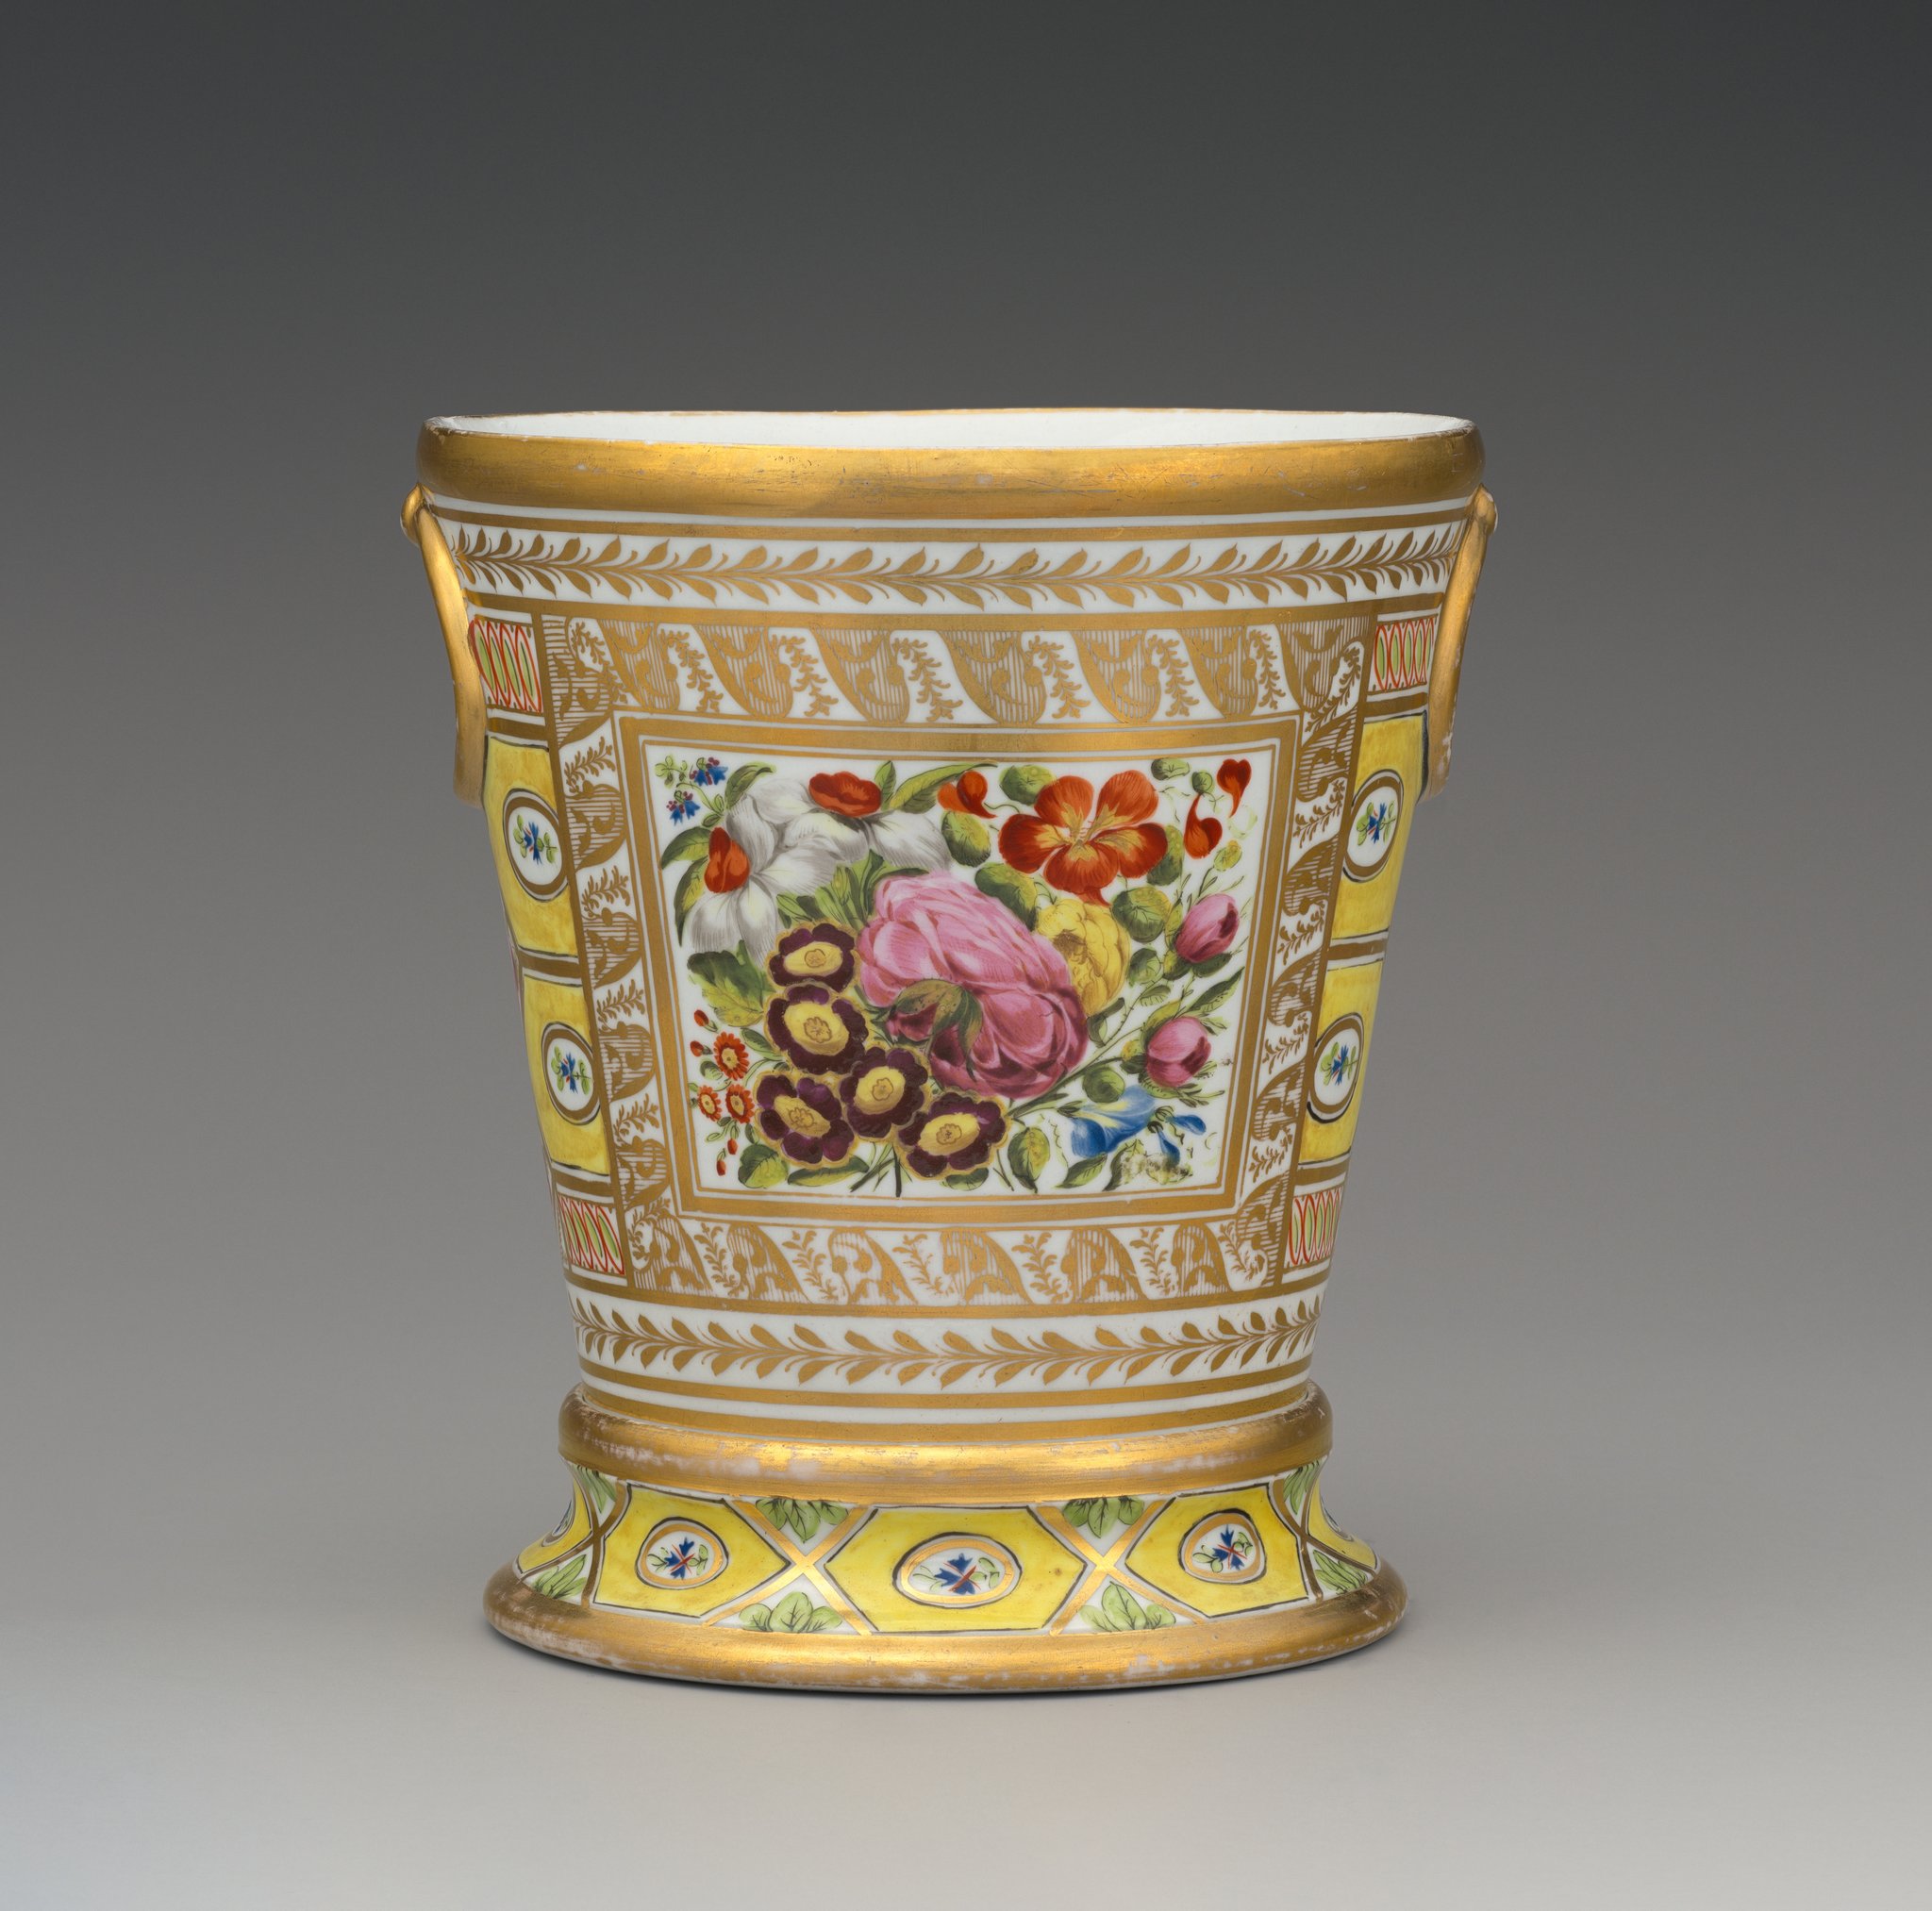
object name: cachepot with stand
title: Cachepot with stand (one of a pair)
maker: coalport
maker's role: factory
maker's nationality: british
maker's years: 1794-1926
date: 1805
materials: soft paste porcelain